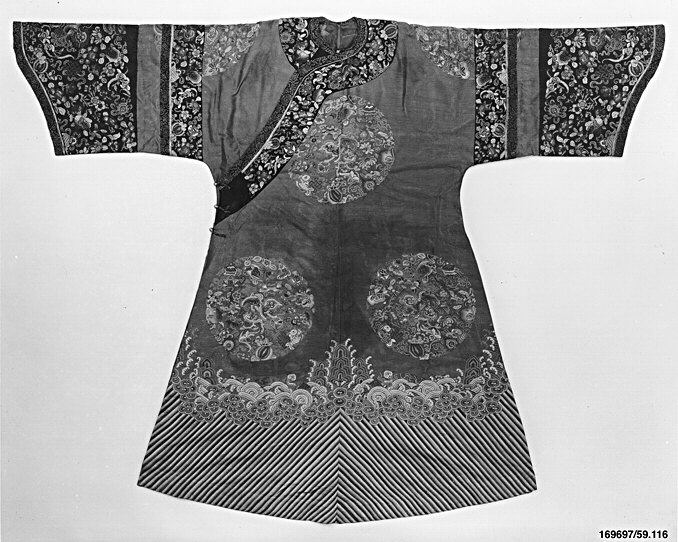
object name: woman's informal robe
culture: chinese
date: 1767-1800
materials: textile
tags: birds